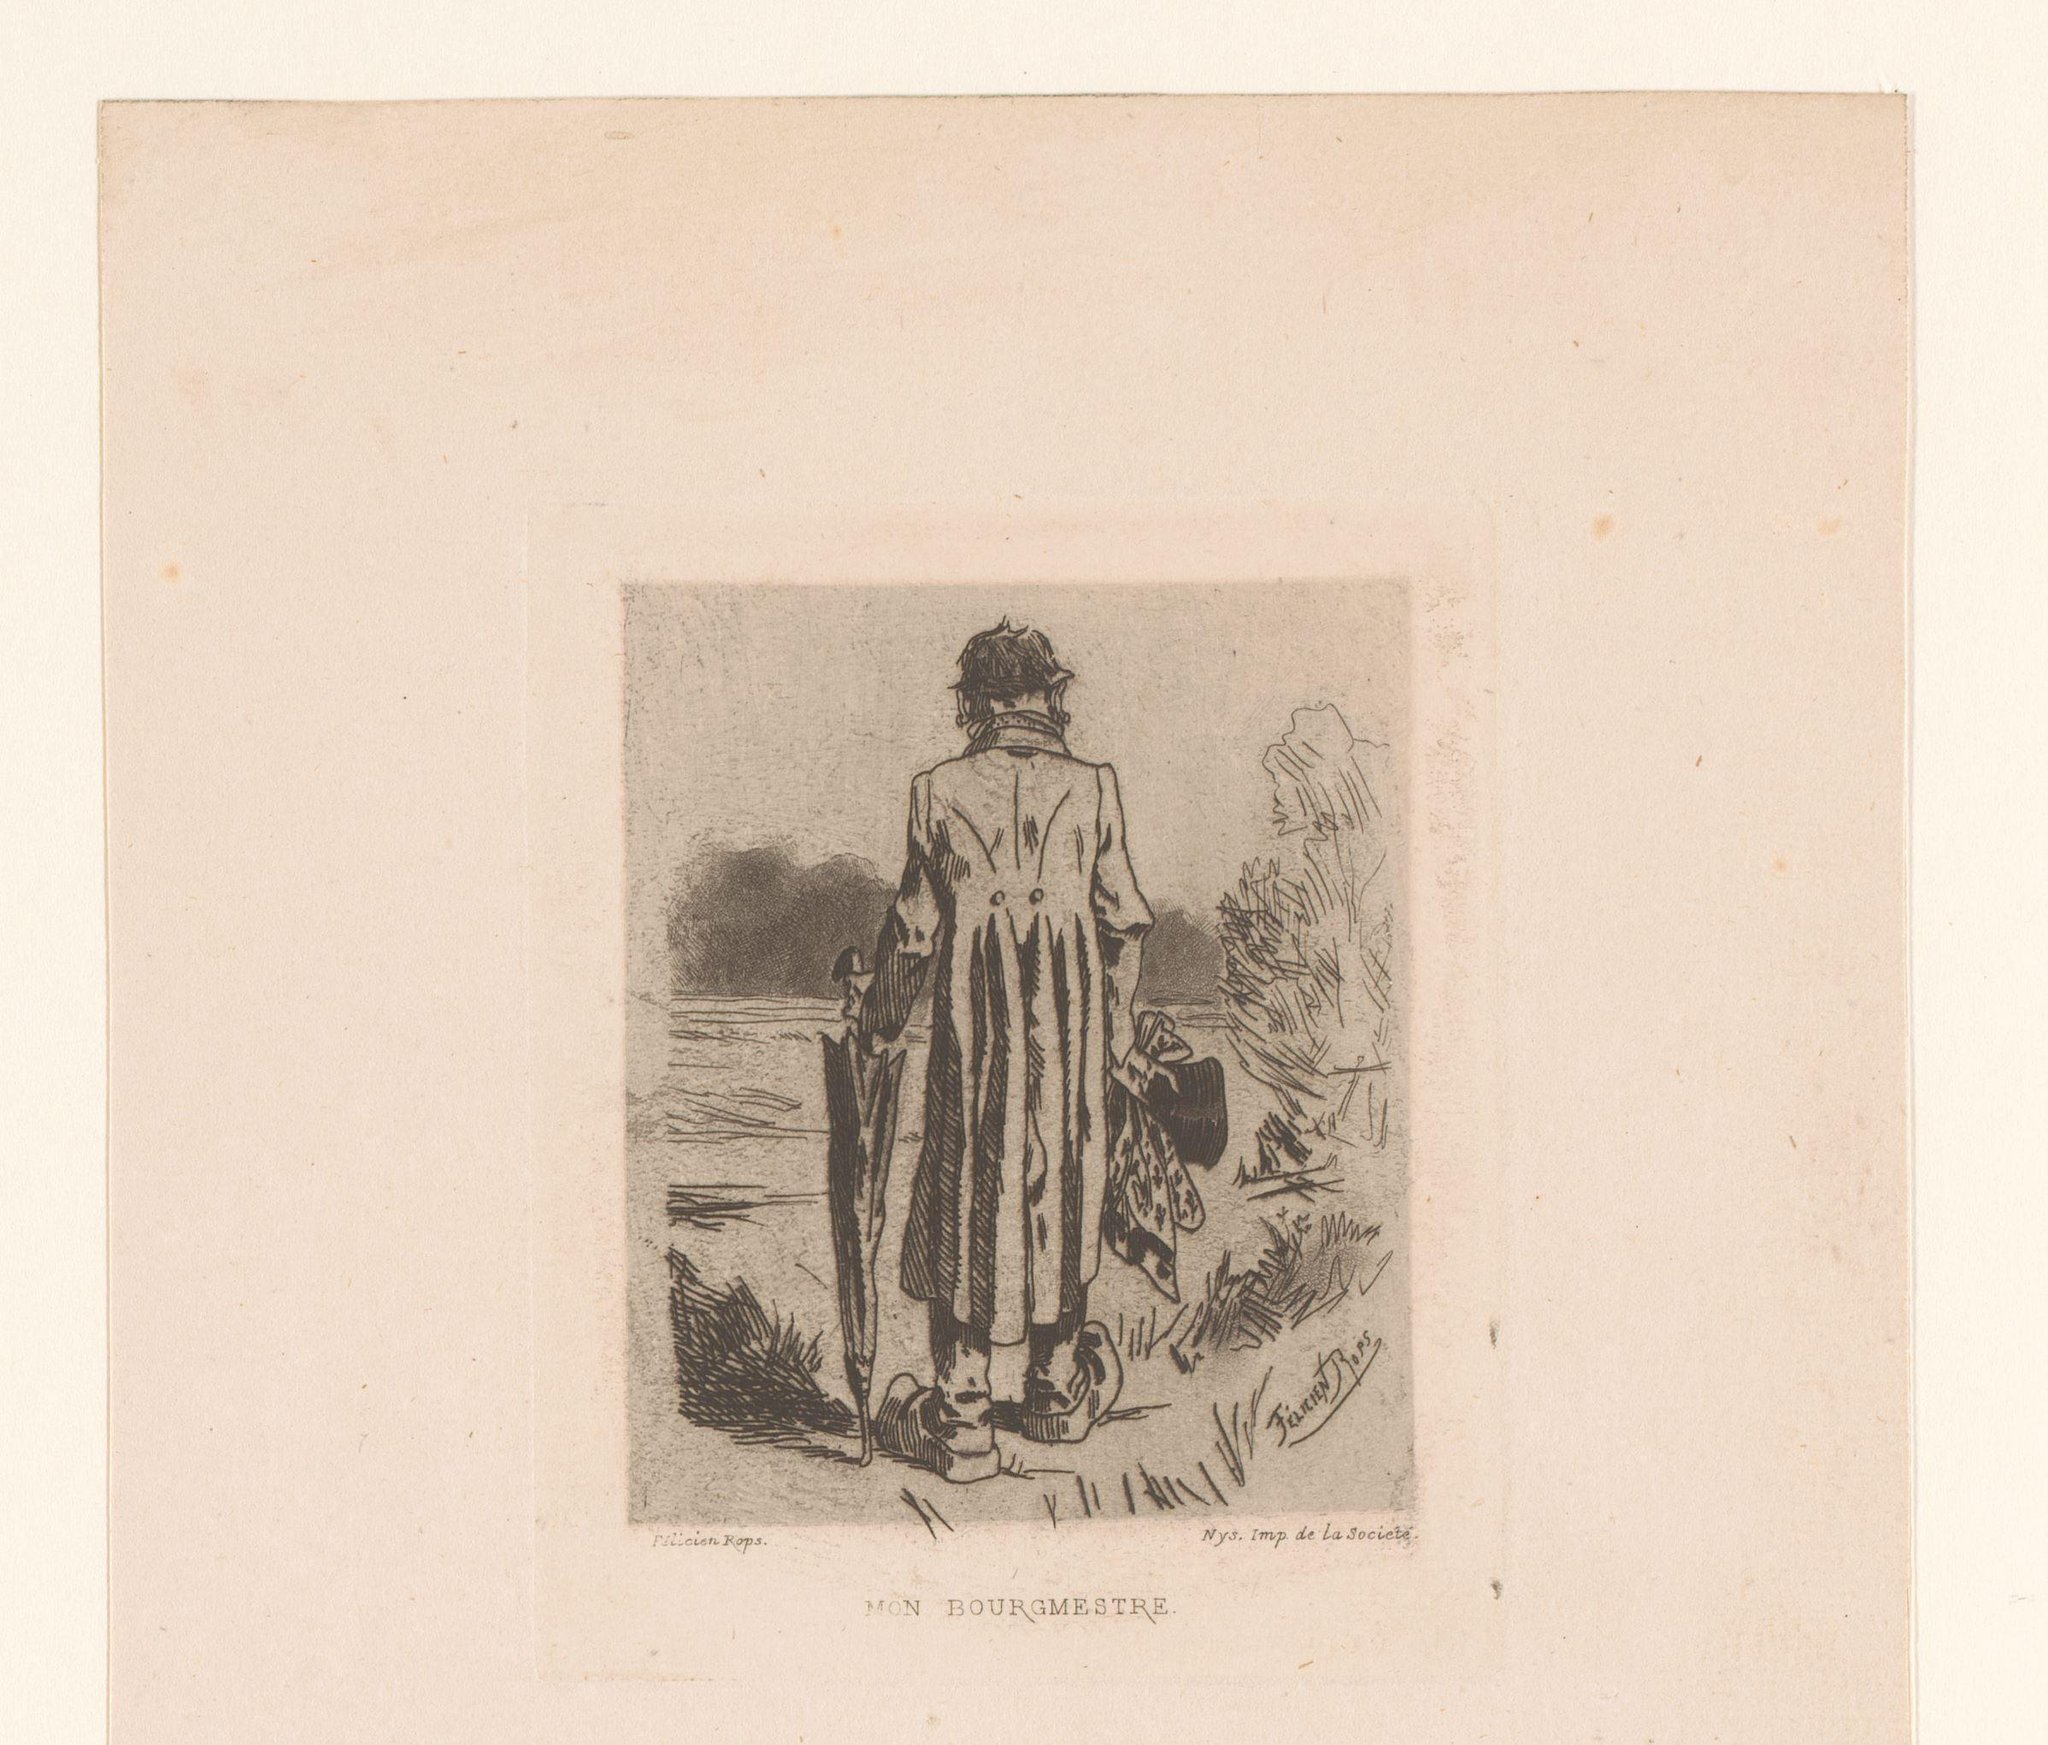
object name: print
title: Mon bourgmestre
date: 1875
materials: paper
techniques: aquatint, etching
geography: brussels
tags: adult man (+ back view)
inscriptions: collector's mark: Lugt 2228